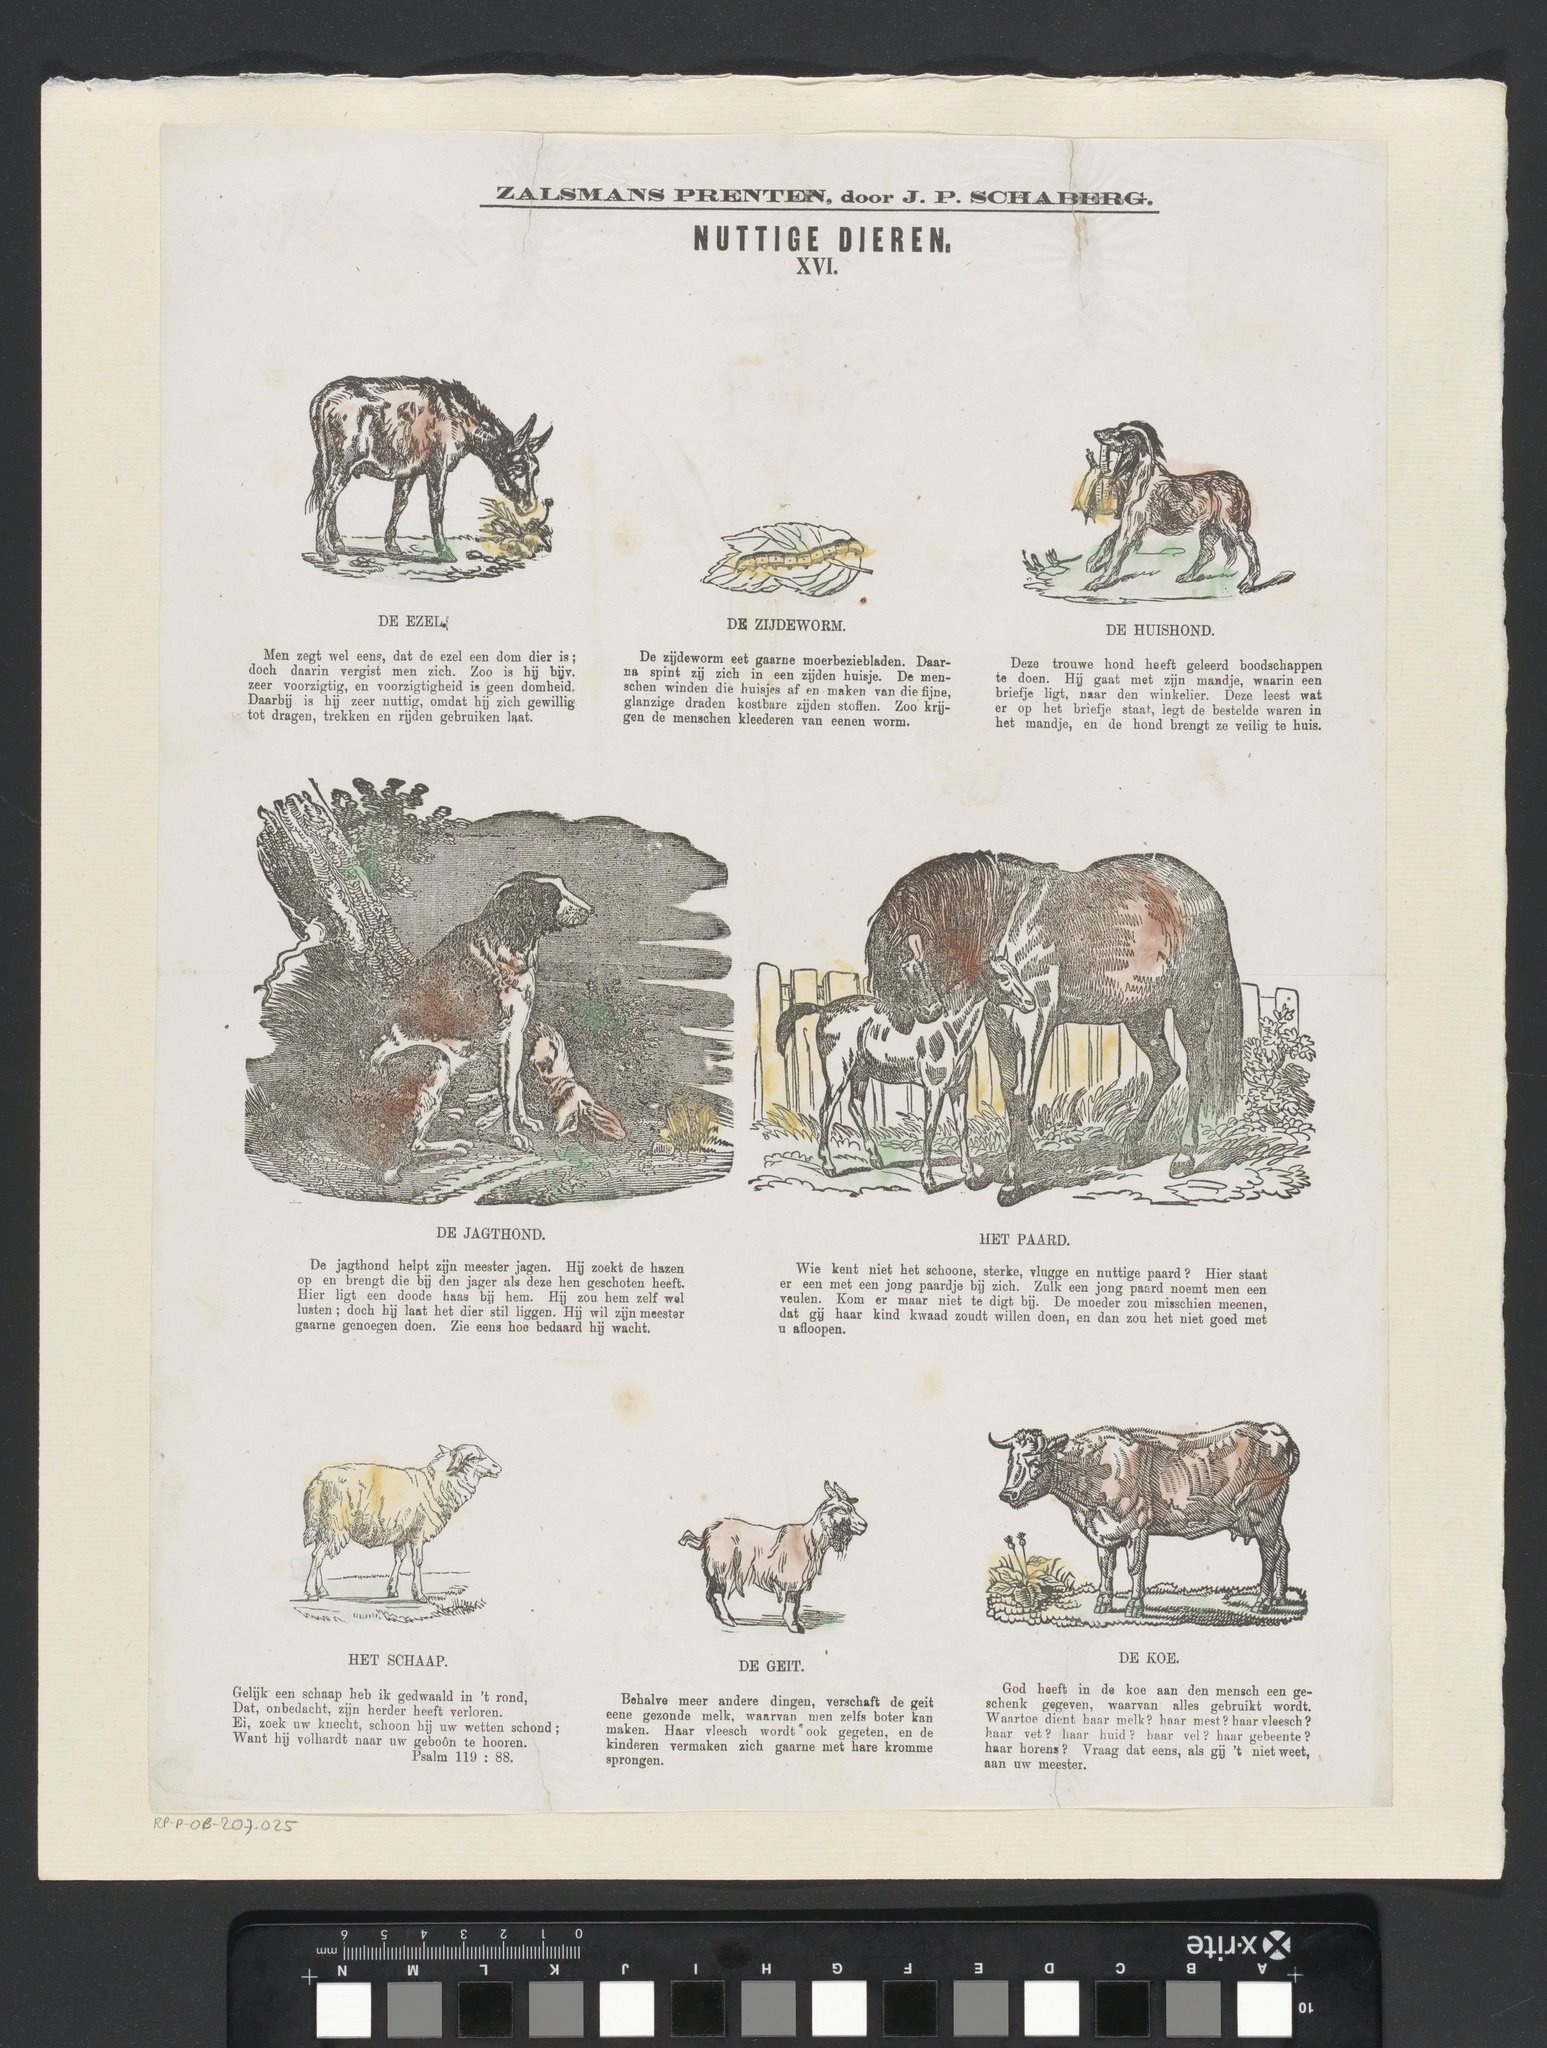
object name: print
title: Nuttige dieren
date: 1869-1882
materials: paper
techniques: colour, letterpress printing, engraving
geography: kampen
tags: animals, ass, donkey, horse, goat, dog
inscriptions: collector's mark: Lugt 2760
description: Blad met 8 voorstellingen van dieren, zoals een ezel, een hond en een geit. Onder elke voorstelling een onderschrift. Genummerd midden boven: XVI.